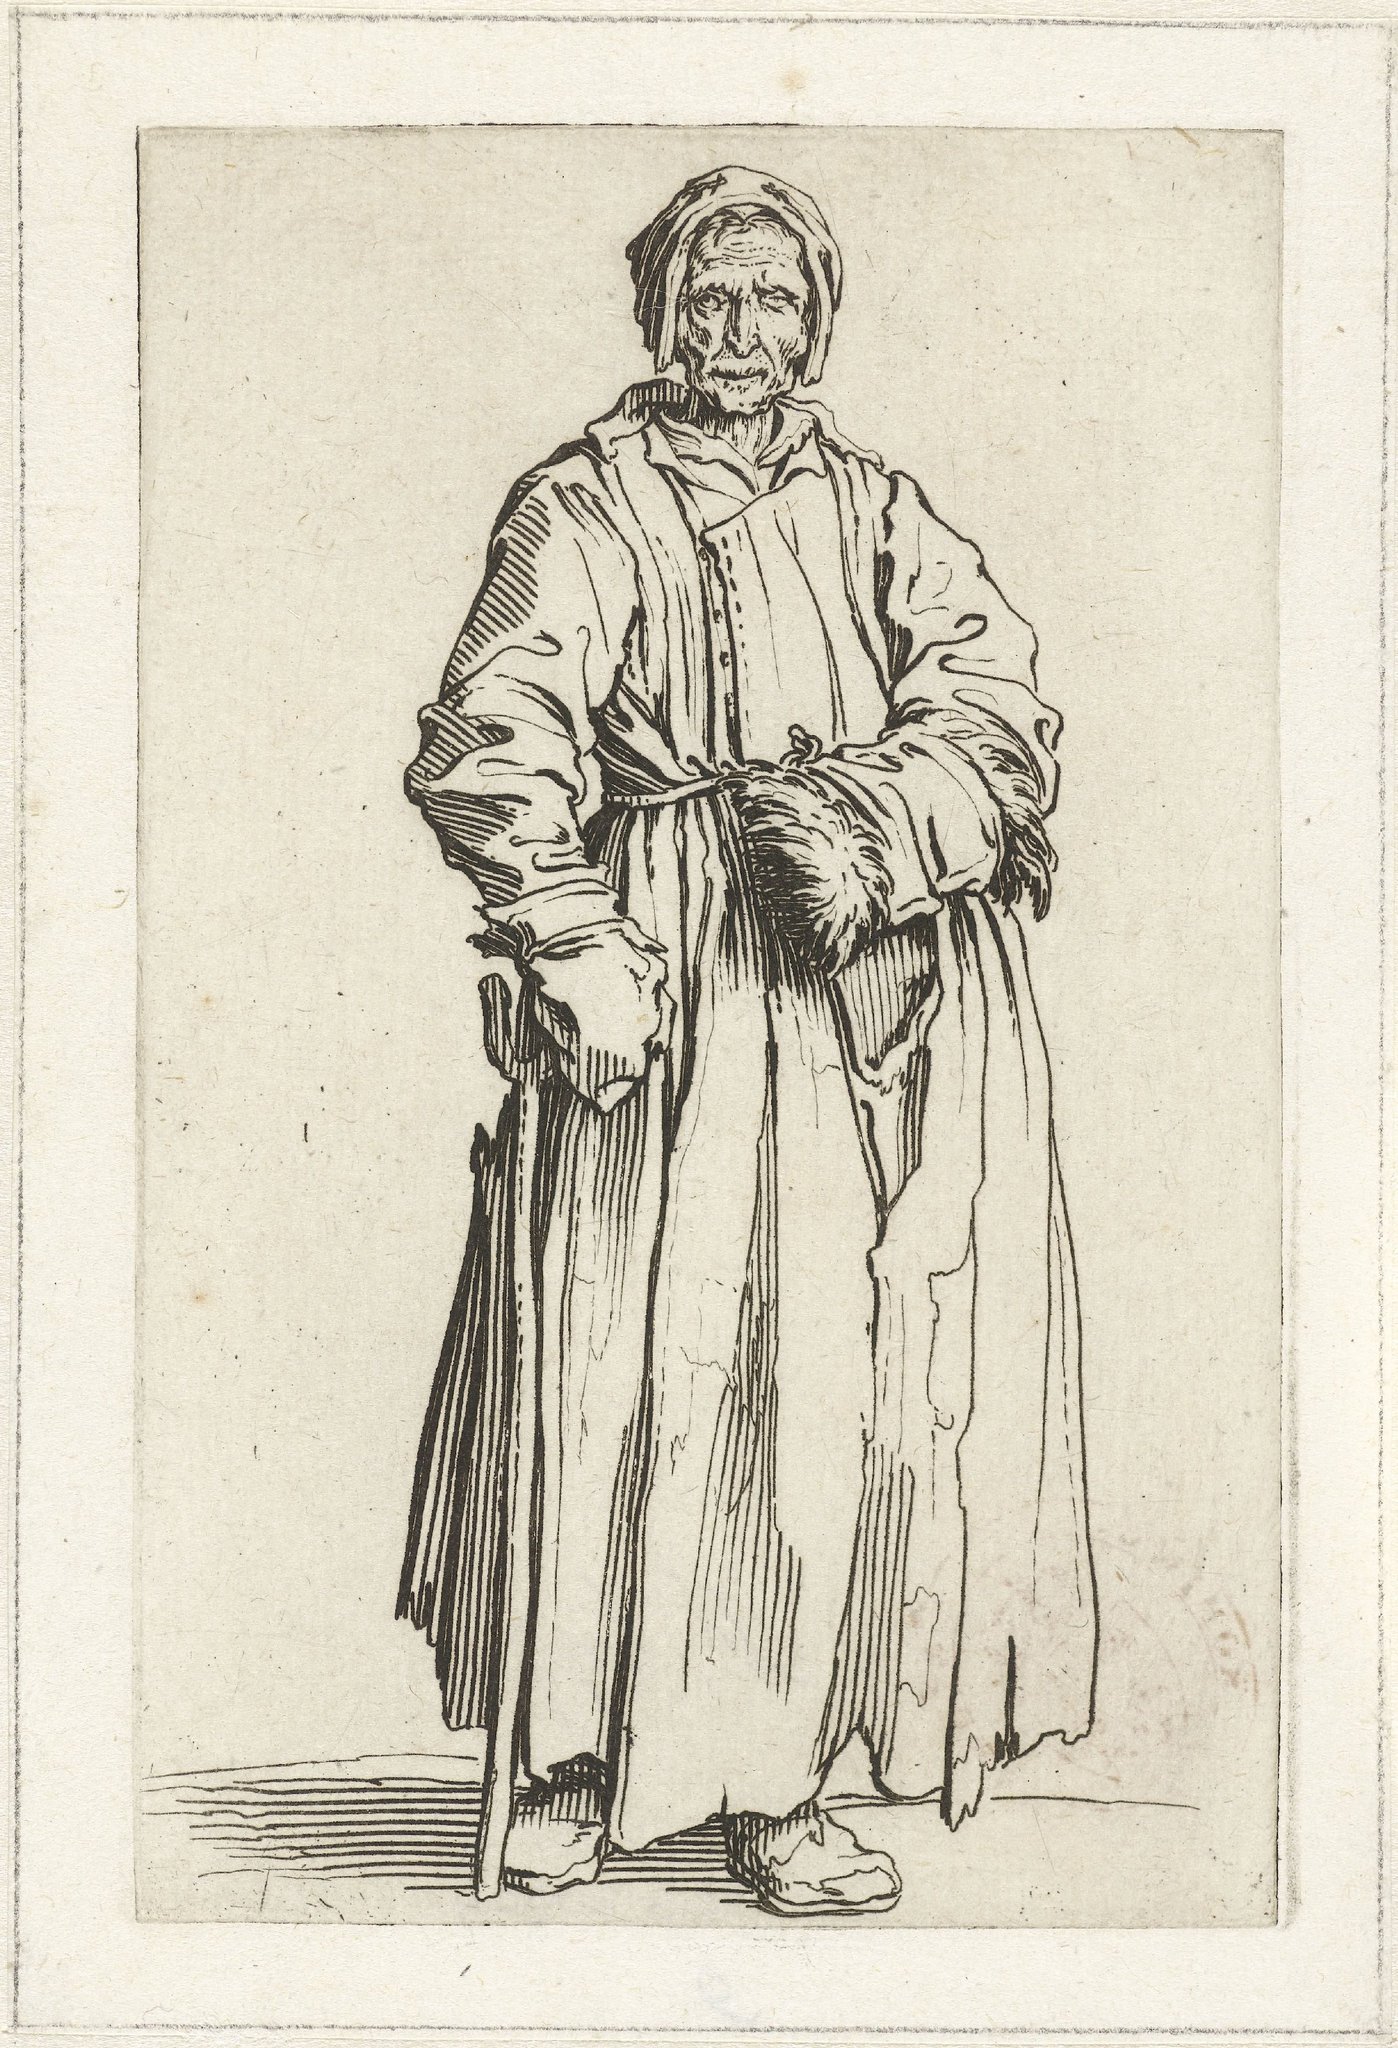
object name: print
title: Bedelaars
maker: jacques callot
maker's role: draughtsman, print maker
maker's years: 1592-1635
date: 1622-1623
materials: paper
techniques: etching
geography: nancy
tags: muff, walking-stick, staff, blind, blindness, beggar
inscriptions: collector's mark: Lugt 240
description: Vrouw, gekleed in lompen, van voren gezien, aan één oog blind, de linkerhand in een mof, met de rechterhand steunend op een stok. Deze prent is onderdeel van een serie van 25 prenten met bedelaars en zwervers, zoals Callot die waarschijnlijk in Italië heeft gezien.